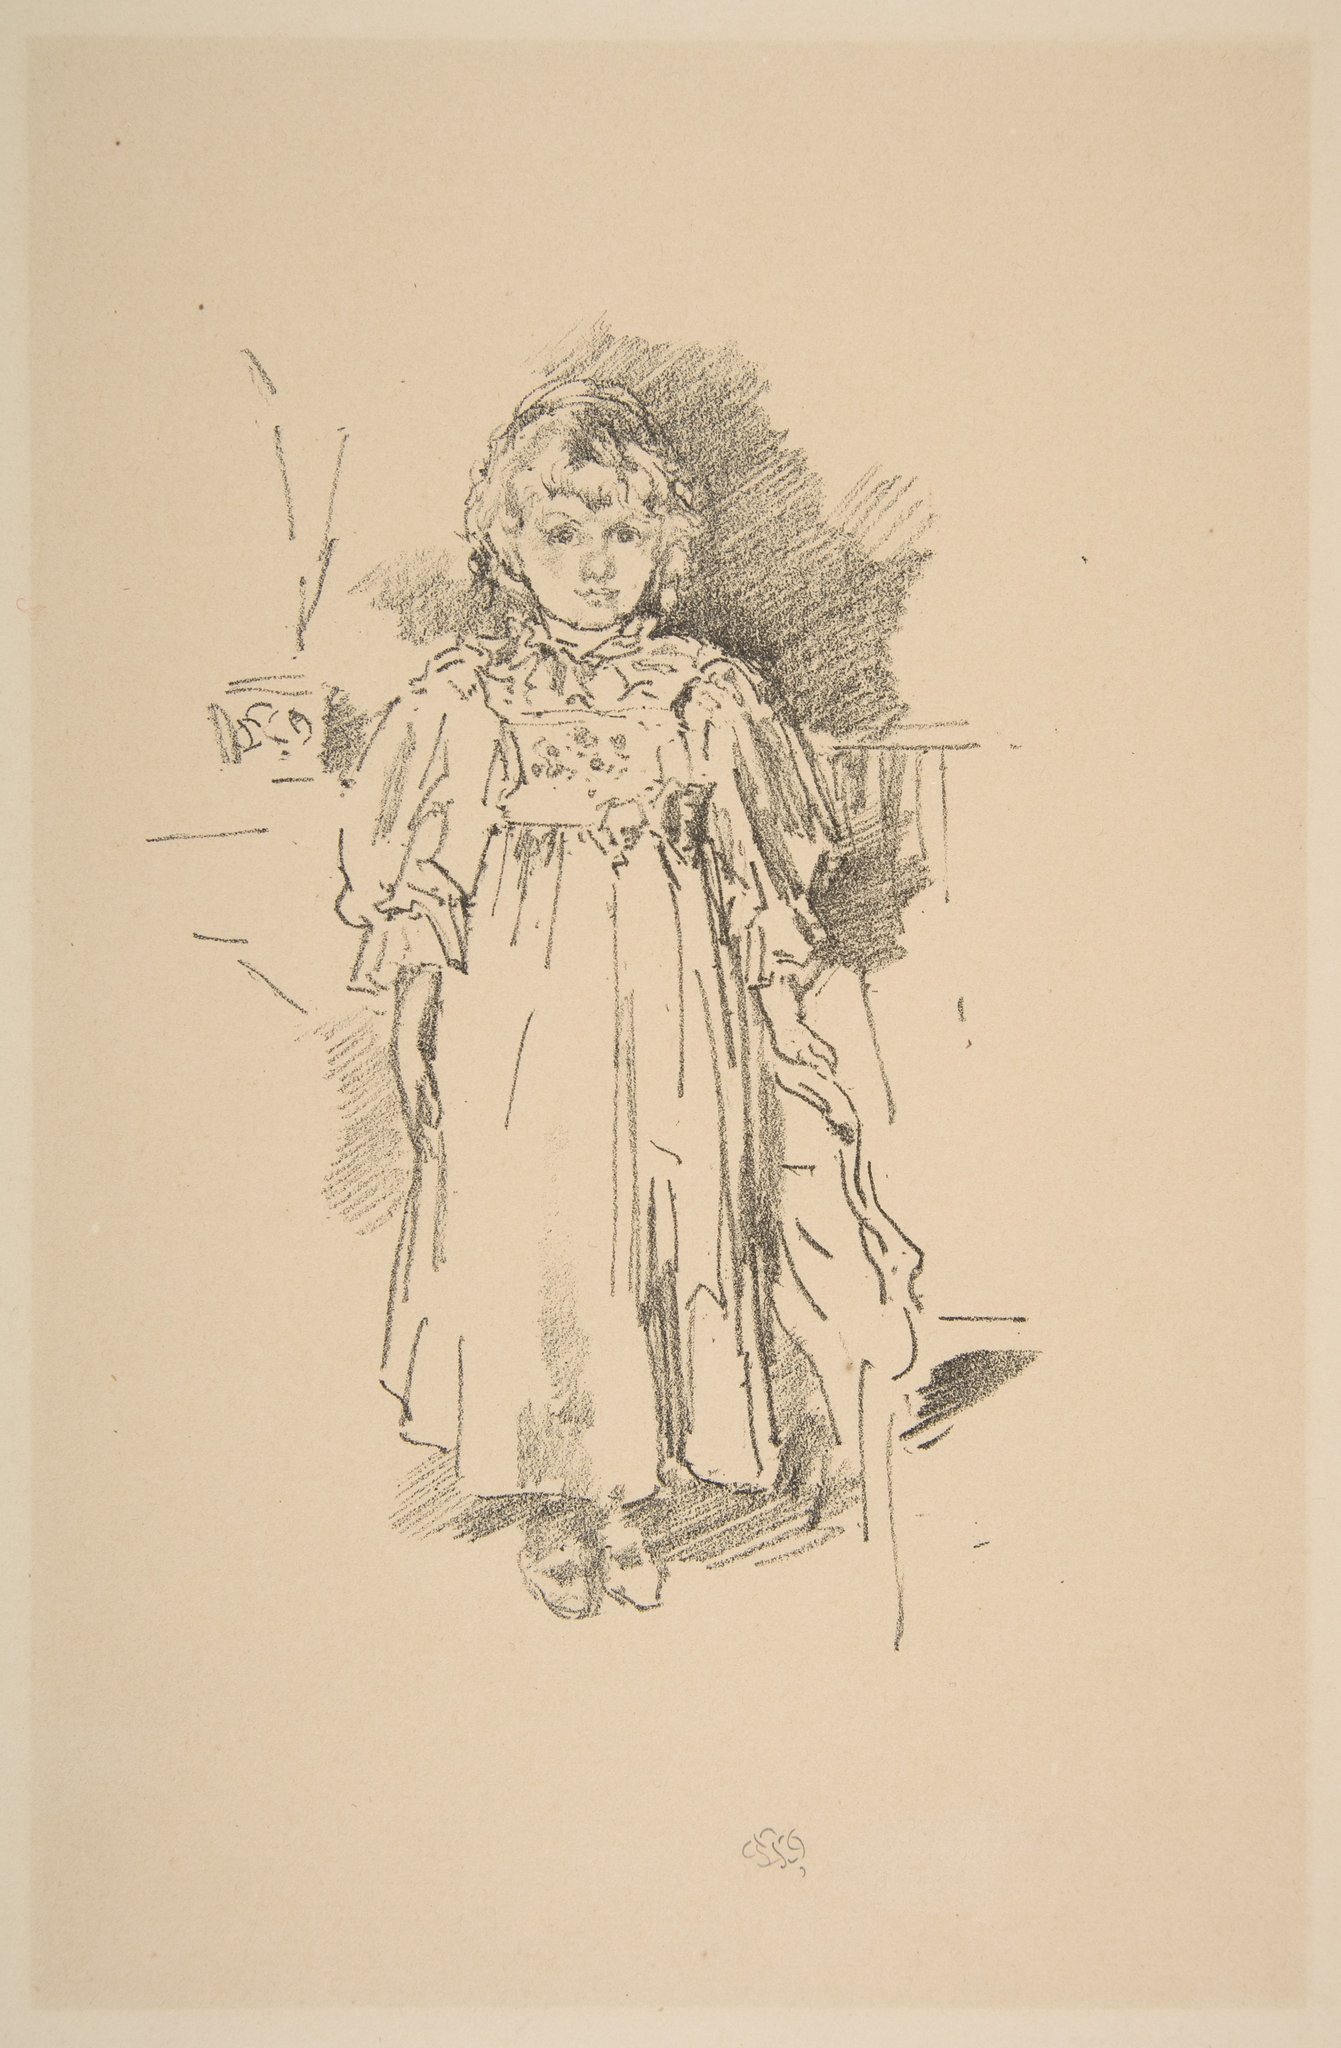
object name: print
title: Little Evelyn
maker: james mcneill whistler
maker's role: artist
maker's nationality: american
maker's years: 1834-1903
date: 1896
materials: ink, paper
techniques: printing, lithography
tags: girls